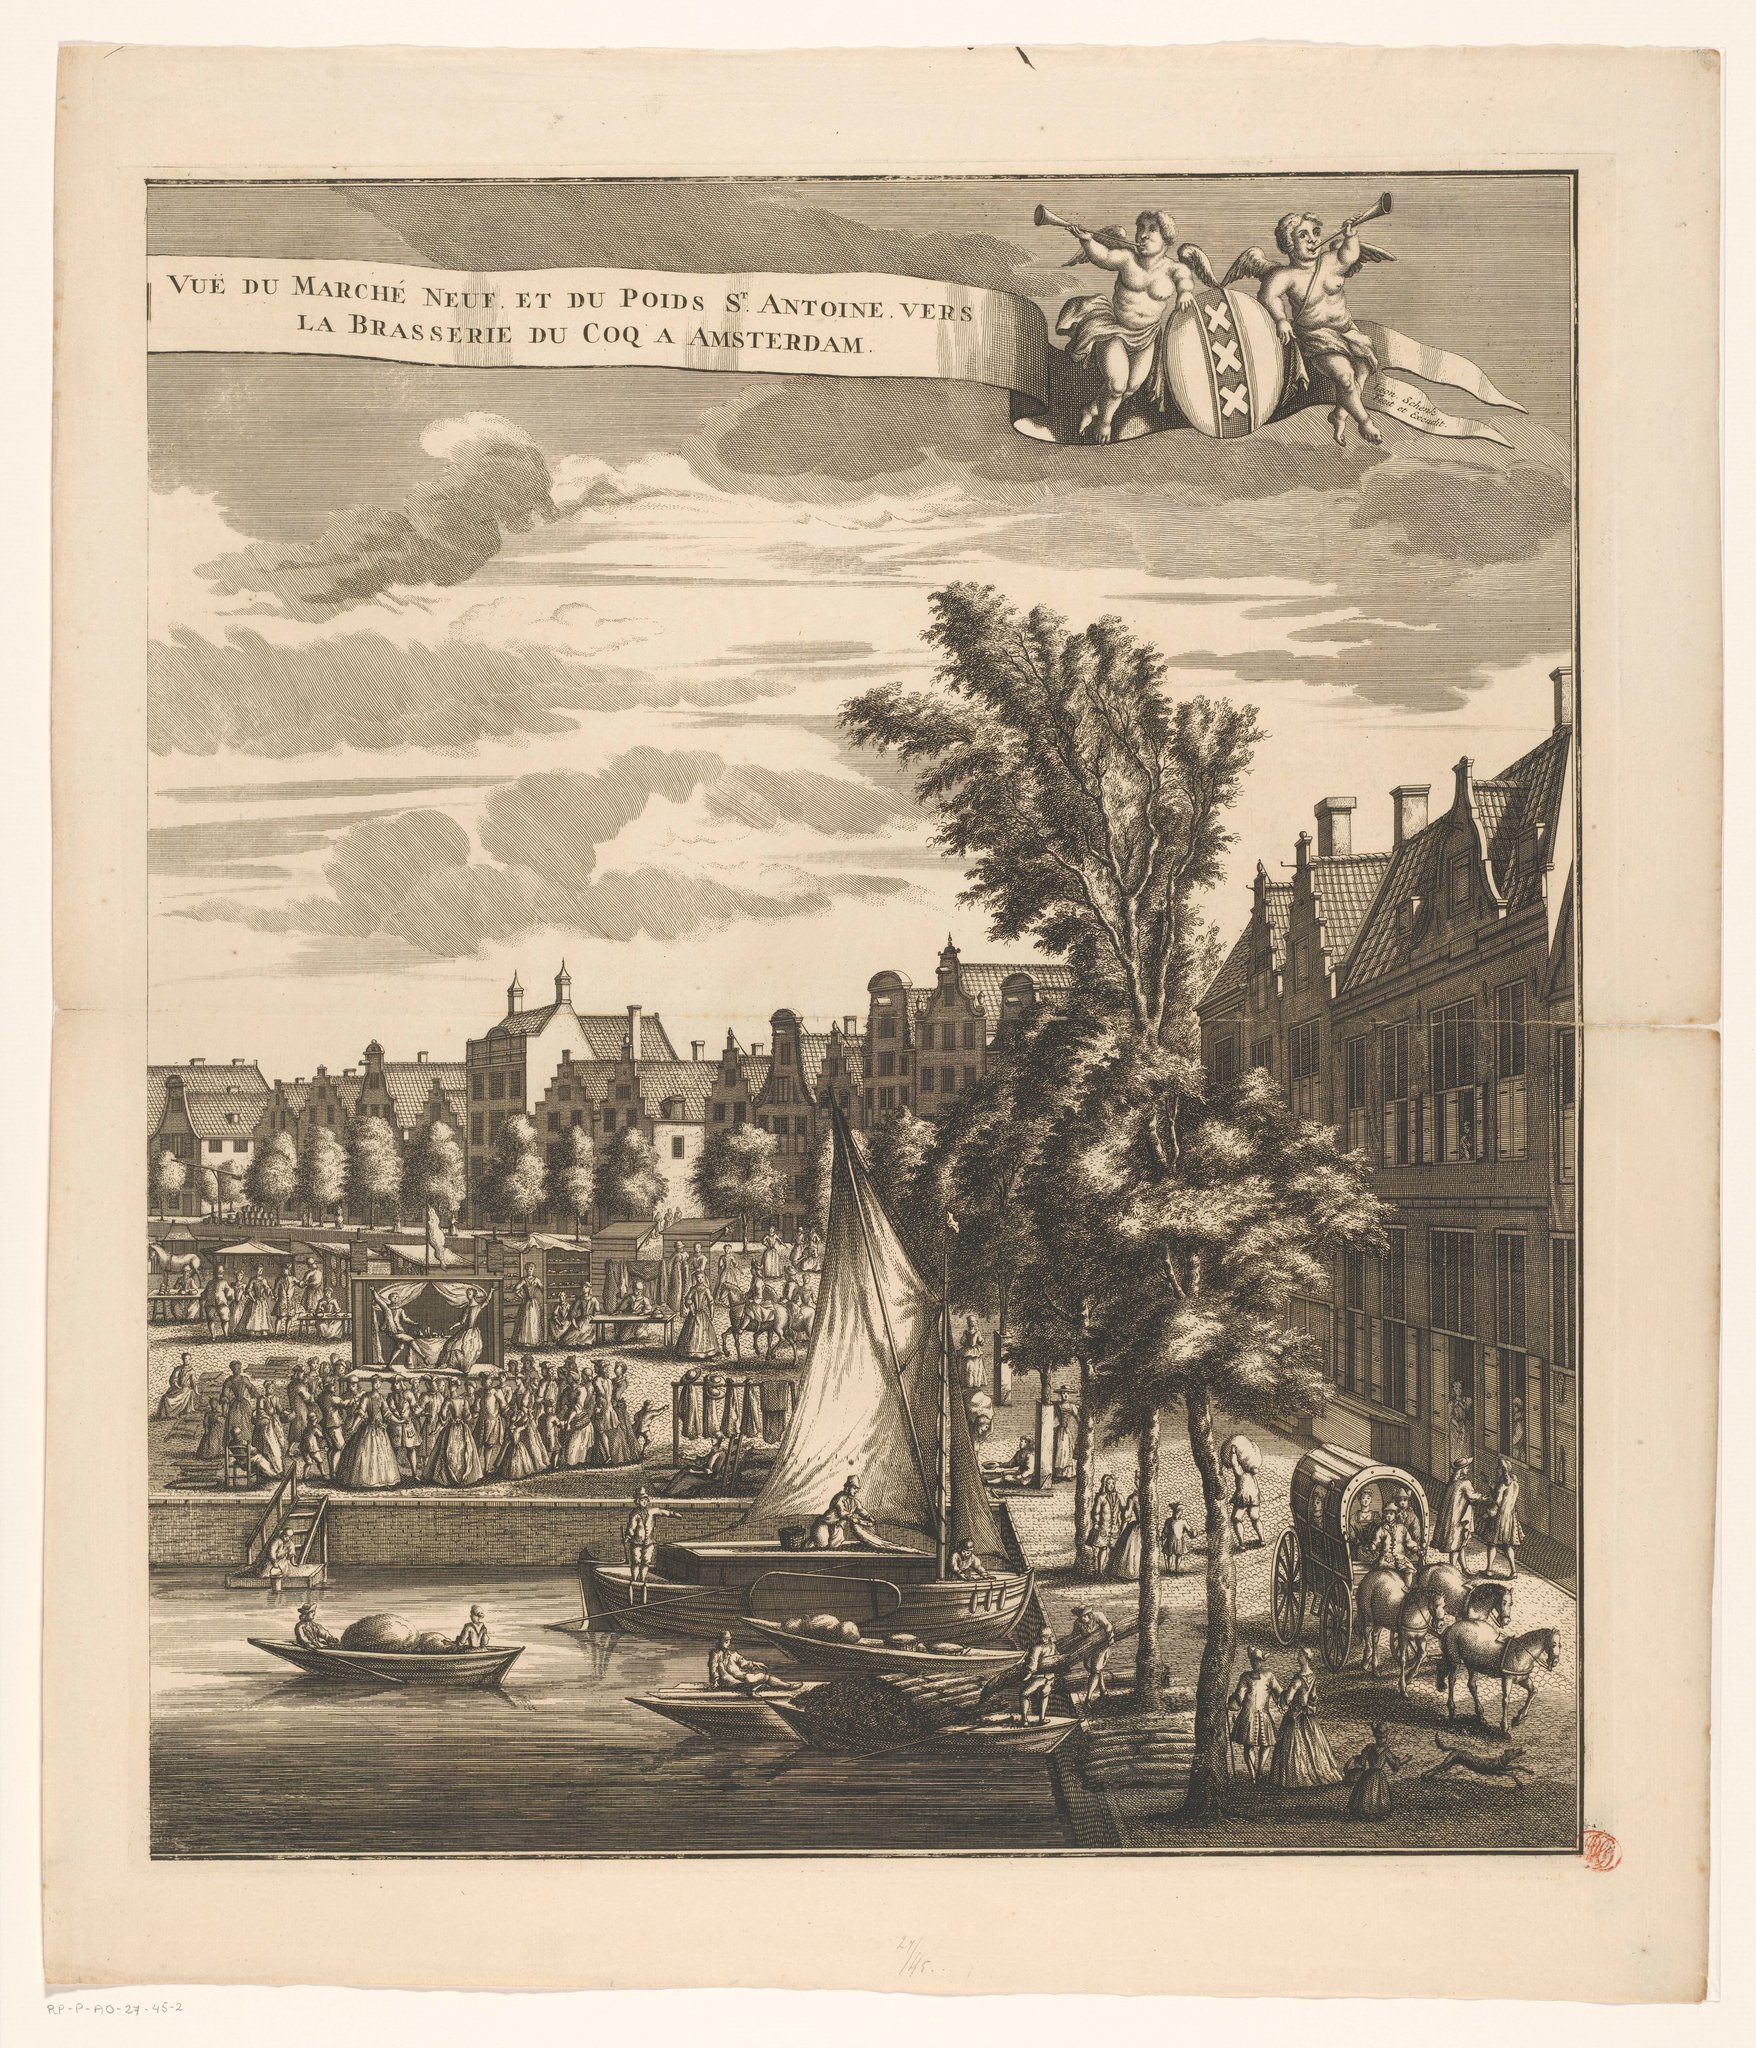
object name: print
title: Gezicht op de Nieuwmarkt te Amsterdam (rechterdeel)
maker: leonard schenk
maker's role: print maker, publisher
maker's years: 1696-1767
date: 1710-1767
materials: paper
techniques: engraving, etching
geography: amsterdam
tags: buildings for performances - aa - open-air performances, coat of arms (as symbol of the state, etc.) (+ city; municipal), stalls ~ theatre, etc. - aa - open-air performances, stall, booth (~ market), ships (in general) - cc - more than one ship, market, square, place, circus, etc. (+ city(-scape) with figures, staffage), canals, waters (in city) (+ city(-scape) with figures, staffage), street (+ city(-scape) with figures, staffage)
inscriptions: collector's mark: Lugt 195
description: Rechterdeel van een gezicht op de Nieuwmarkt te Amsterdam, bestaande uit twee delen.